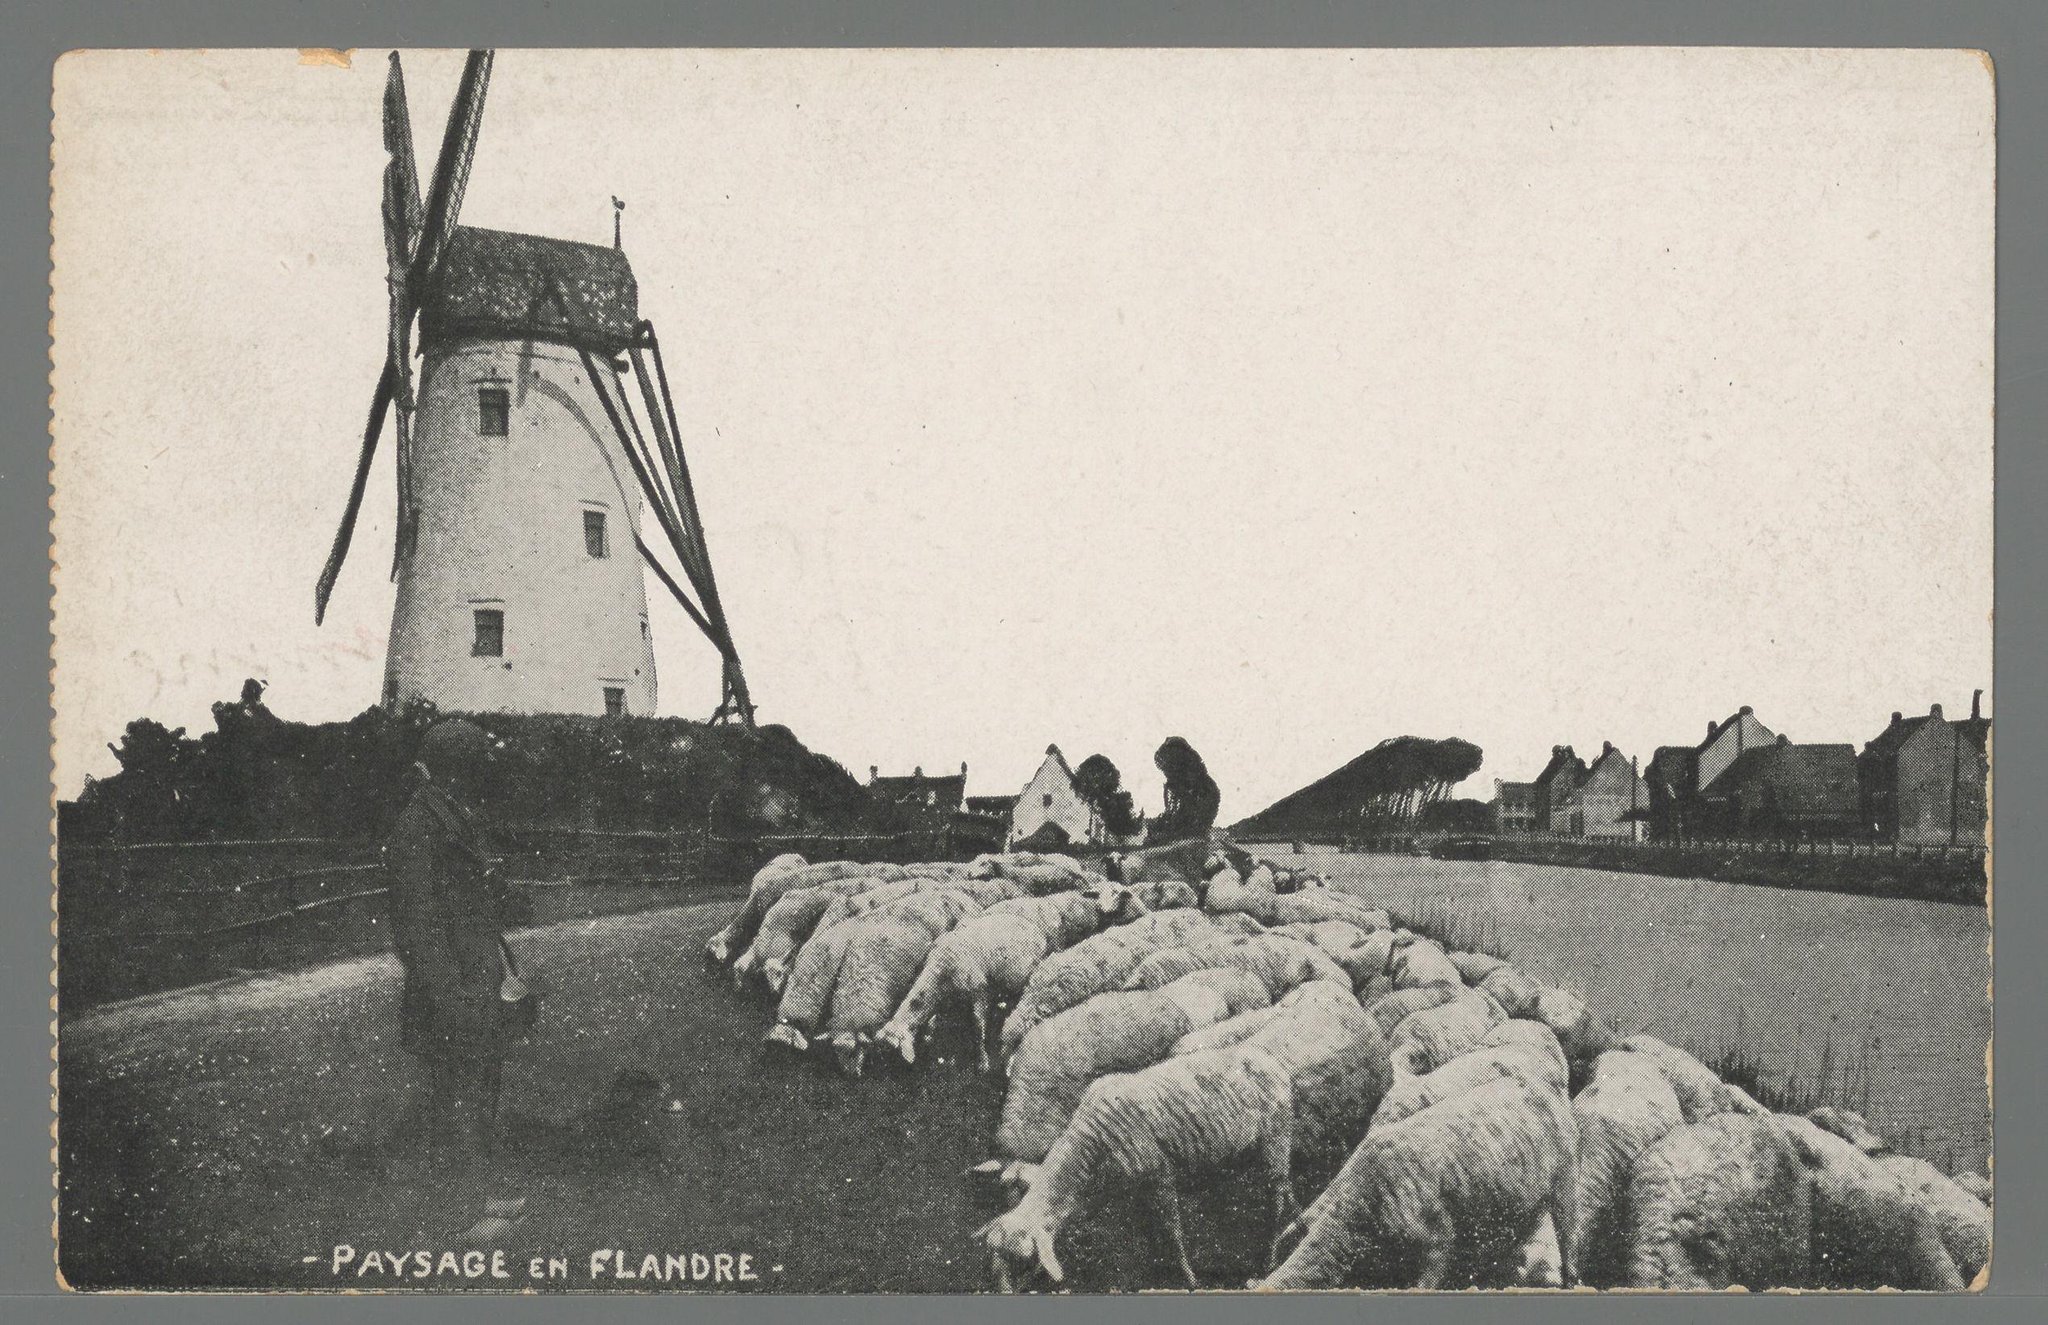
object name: photomechanical print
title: Paysage en Flandre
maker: Anonymous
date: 1906-1930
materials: cardboard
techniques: autotype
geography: flanders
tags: canal, windmill in landscape, sheep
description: Windmolen en herder met schapen bij een vaart, mogelijk bij Damme.